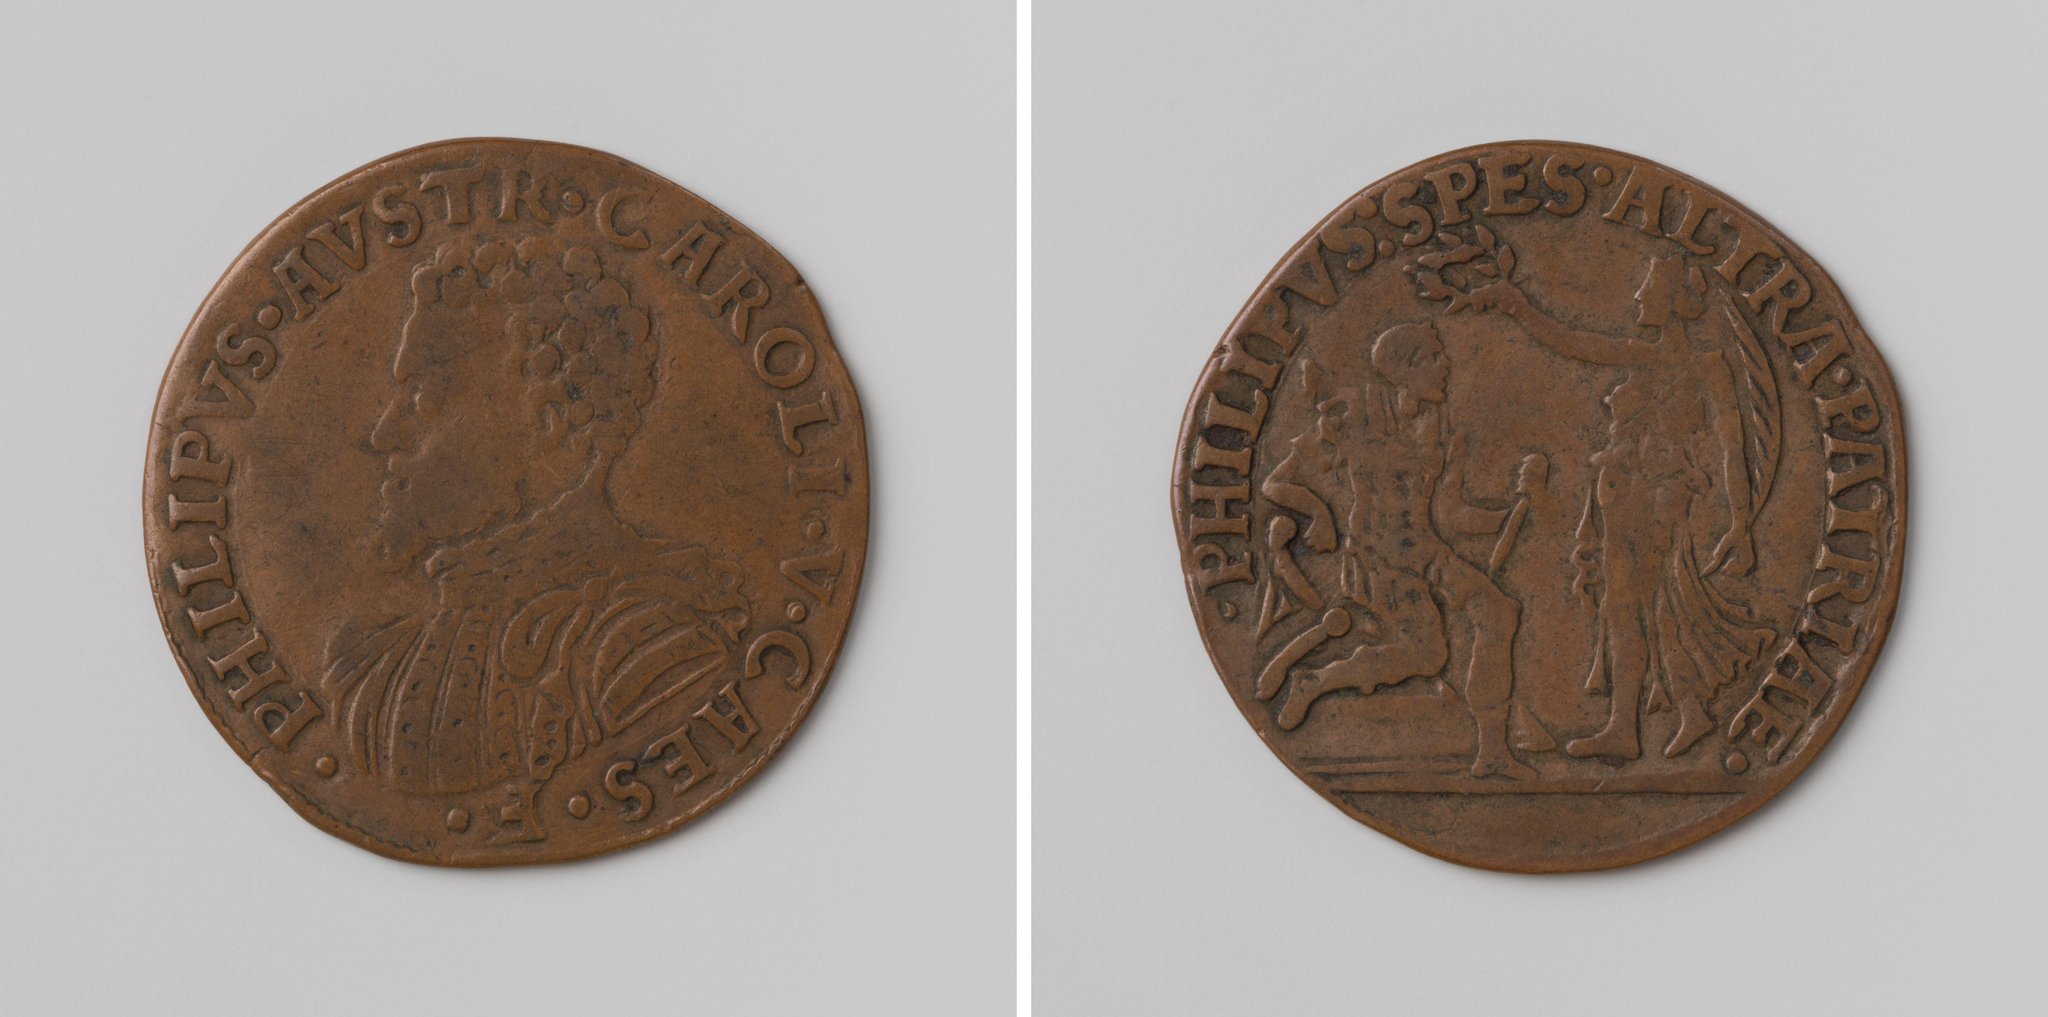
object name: jeton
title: Filips, erfprins van Spanje, heer der Nederlanden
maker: Anonymous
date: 1555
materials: copper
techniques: striking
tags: philip ii of spain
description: Koperen penning. Voorzijde: borststuk man binnen omschrift. Keerzijde: staande vrouw, voorstellende Overwinning, houdt palmtak in linkerhand en houdt met uitgestrekte rechterhand een lauwerkrans boven hoofd van Filips, die in Romeins tenue gekleed, op stoel zit met commandostaf in hand binnen omschrift